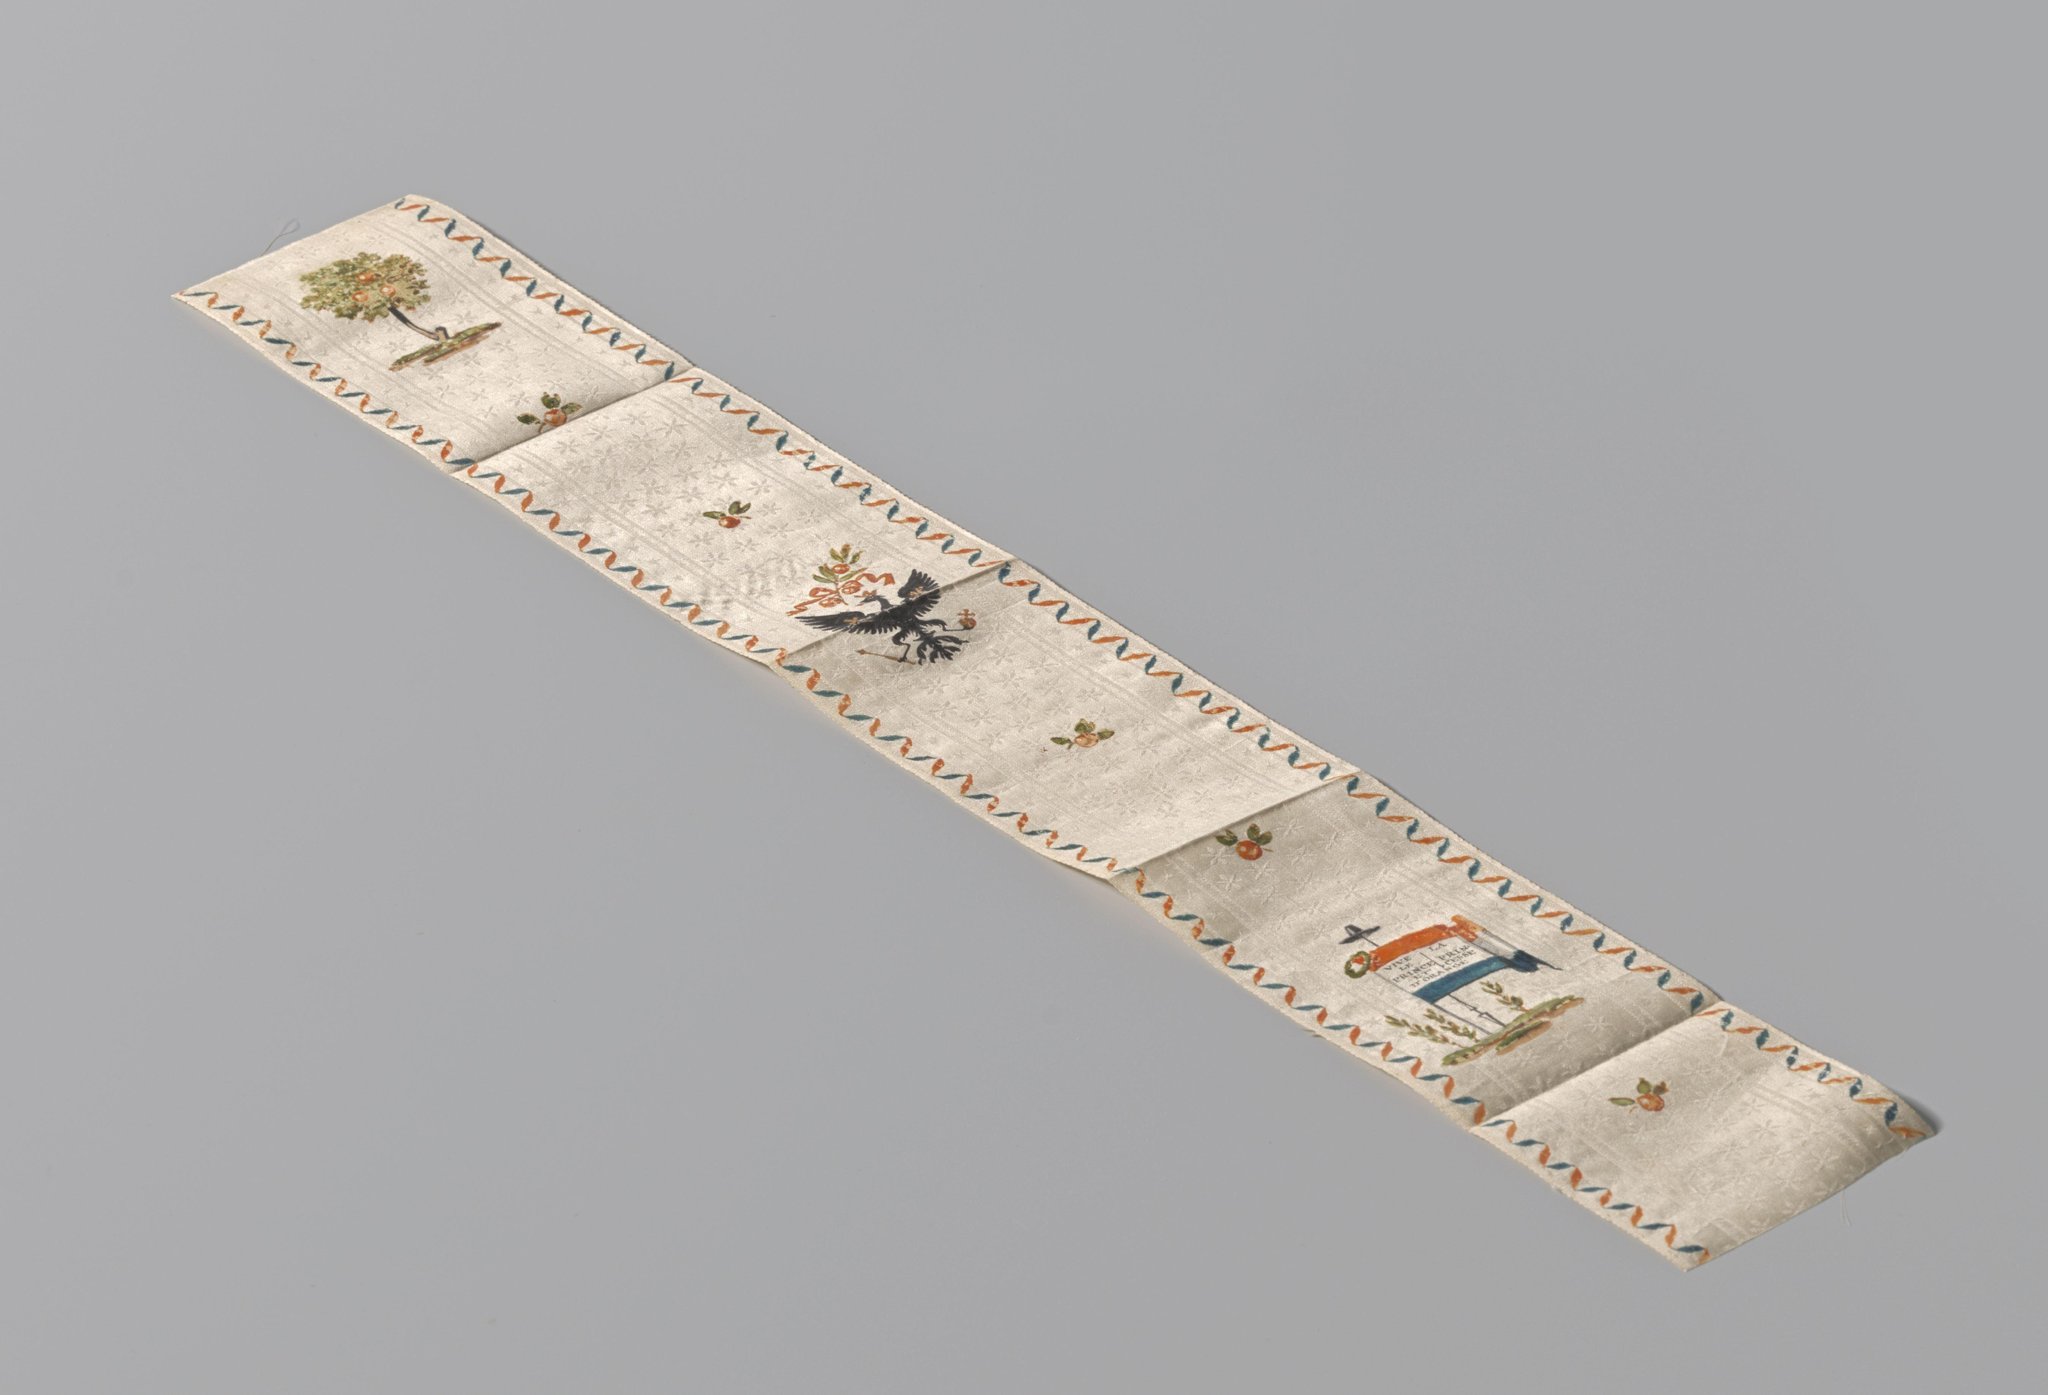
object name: ribbon material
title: Oranjelint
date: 1725-1750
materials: silk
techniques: printing, weave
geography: netherlands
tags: the hague, william v (prince of orange), berlin, draughtsman, wilhelmina of prussia (princess of orange)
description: Lint met ingeweven stermotieven en een drietal opgedrukte voorstellingen: - Oranjeboom. - Pruissische adelaar met boven het hoofd een tak met oranje-appelen. - Nederlandse vlag met om de stok lauwerkrans. Op de achtergrond een lans met vrijheidshoed om de punt. De voorstellingen zijn van elkaar gescheiden door oranje-appelen. Opschrift: VIVE LE PRINCE ET LA PRINCESSE D'ORANGE.